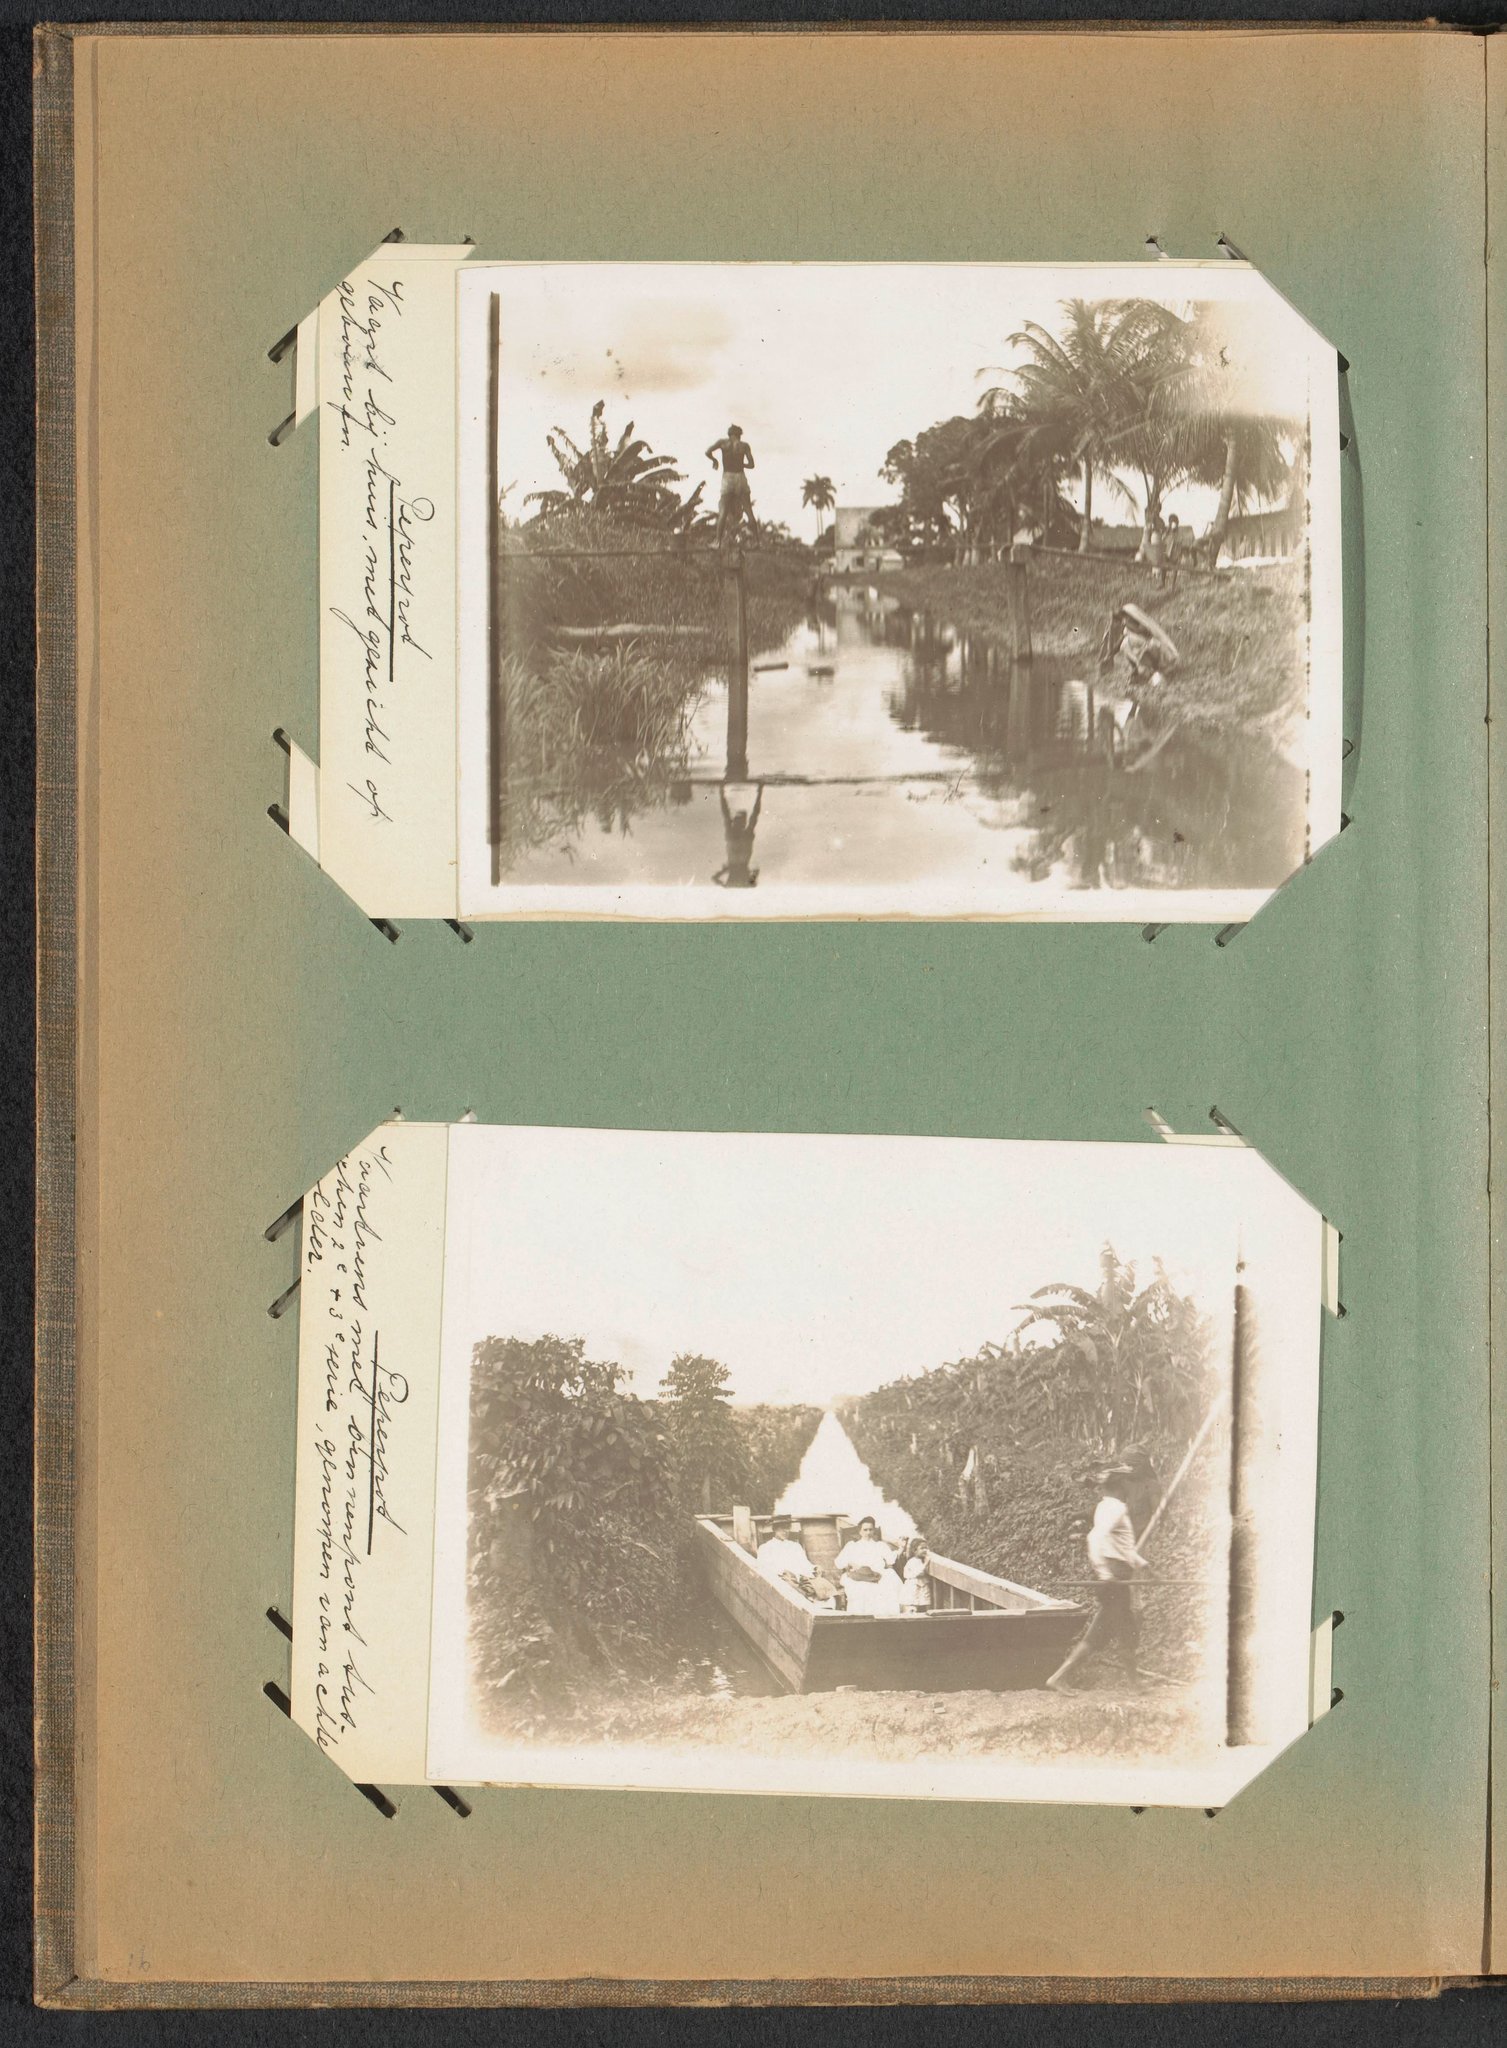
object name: photograph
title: Gezin in boot op Plantage Peperpot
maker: Anonymous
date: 1912-1913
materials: paper, photographic support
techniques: gelatin silver print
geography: suriname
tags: plantation, outing, pleasure trip, suriname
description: Nederlands (?) gezin in boot op Plantage Peperpot in Suriname. Onderdeel van het fotoalbum uit ca. 1912-1913 met 92 foto's van de plantages Peperpot en Dordrecht in Suriname en Mount Pleasant op Curaçao.